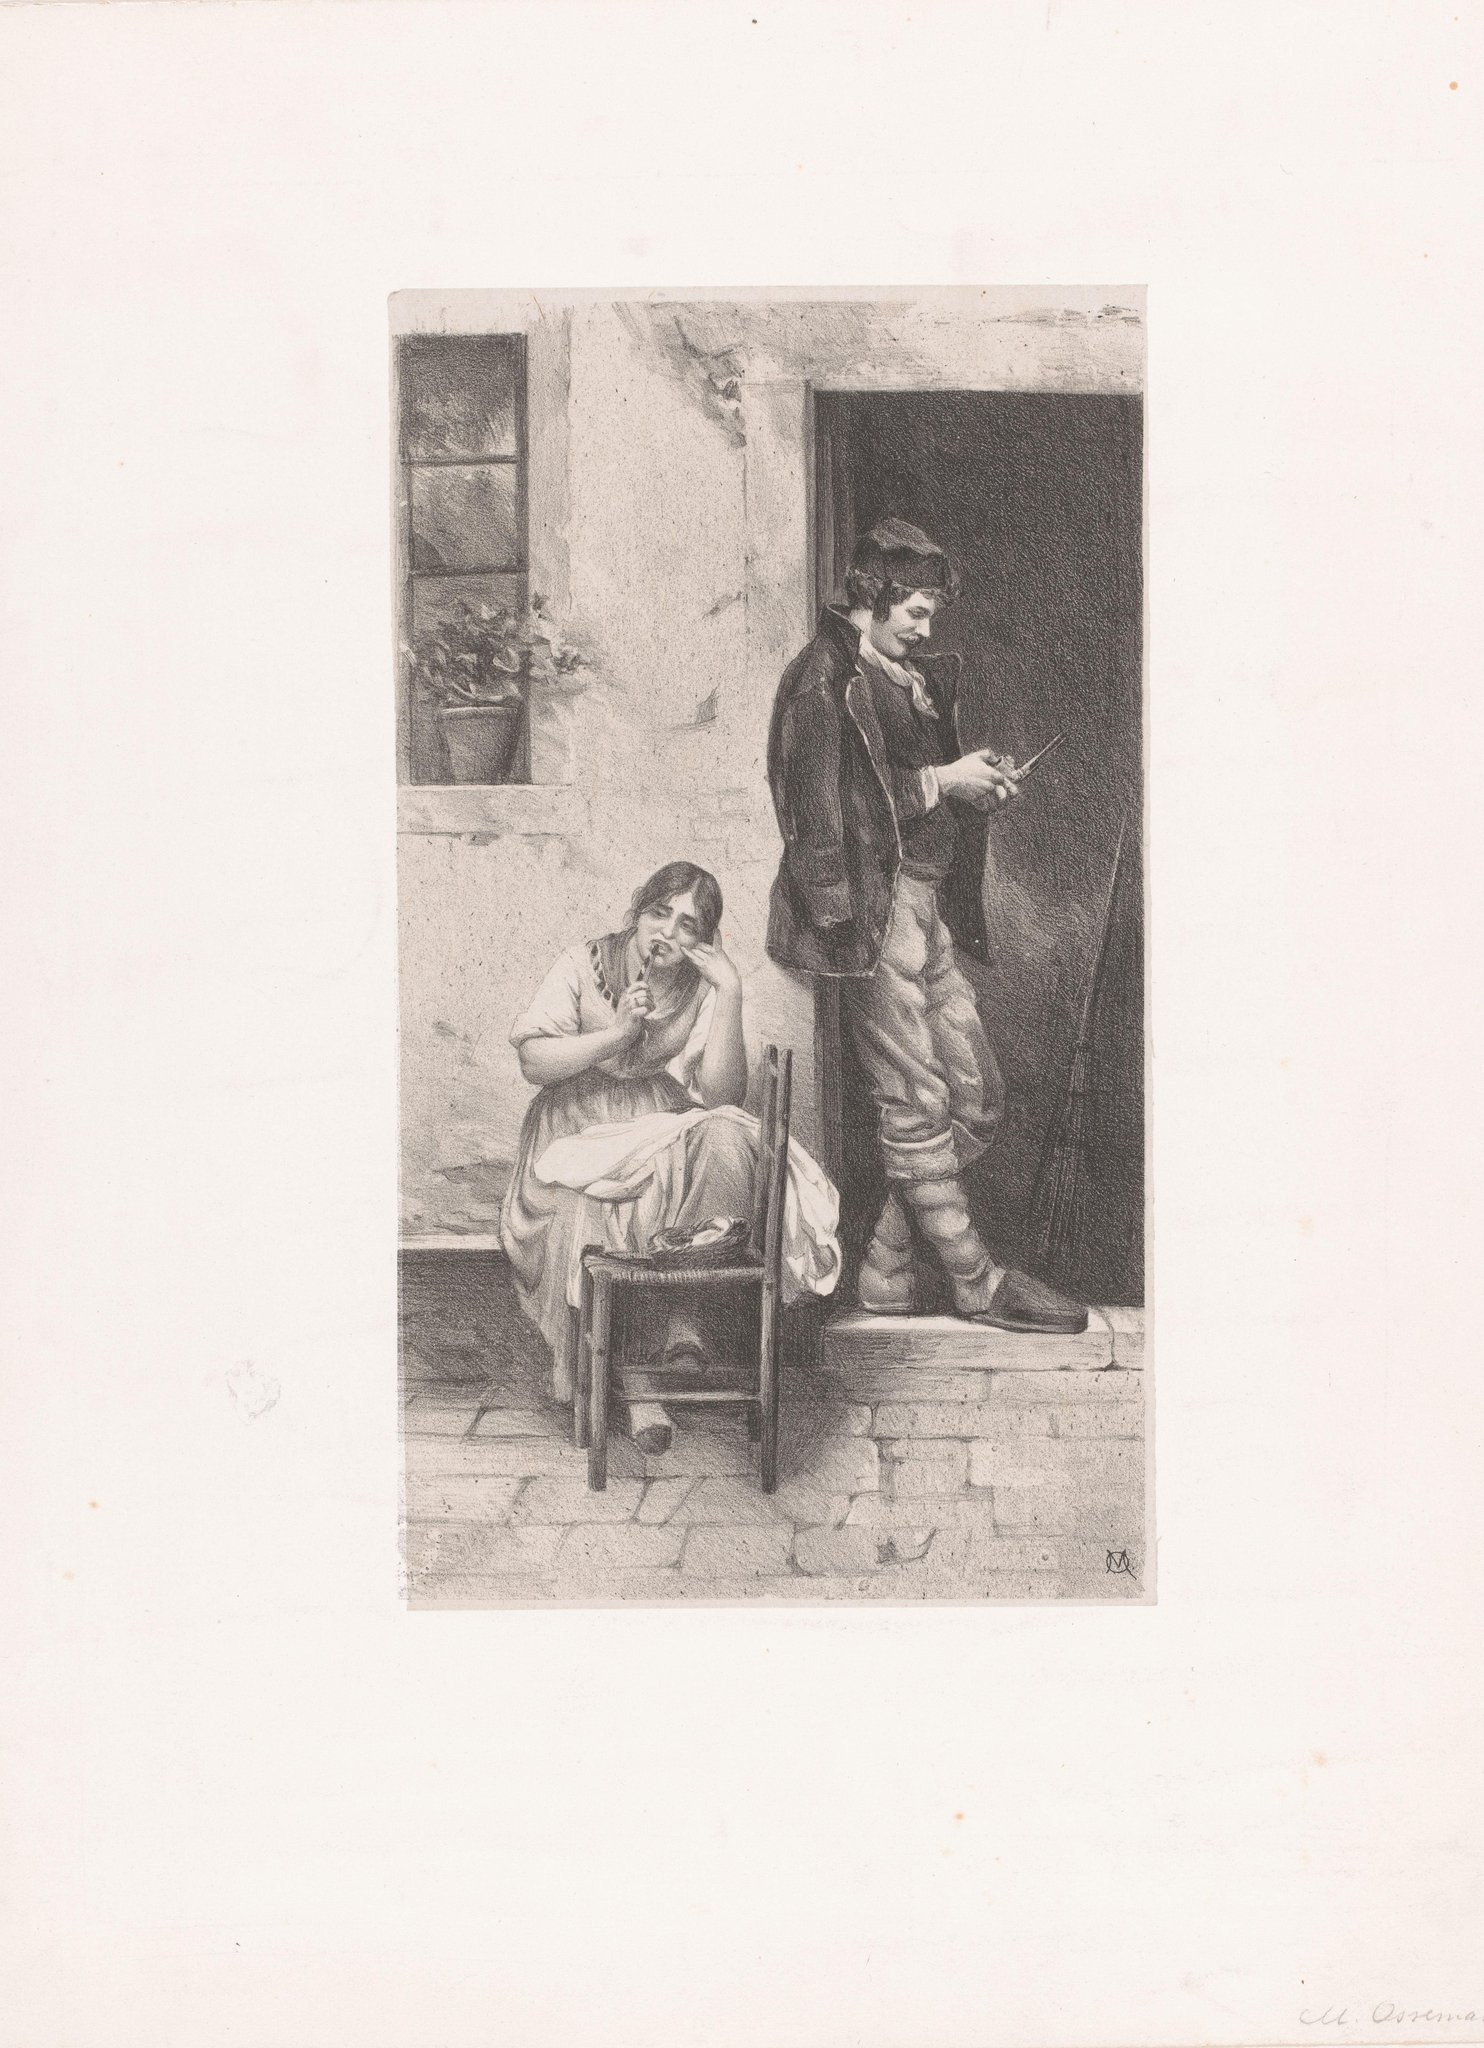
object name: print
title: Man en vrouw voor een huis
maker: maria osseman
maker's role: print maker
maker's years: 1871-1935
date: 1809-1913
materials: paper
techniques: lithograph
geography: netherlands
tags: sitting figure - aa - female human figure, leaning figure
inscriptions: collector's mark: Lugt 2233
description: Tegen de post van een deuropening staat een man geleund met een vuurwapen in zijn hand. Buiten naast de man zit een vrouw op een stoep met haar voeten op het onderstel van de stoel voor haar. Op de stoel staat een mand.